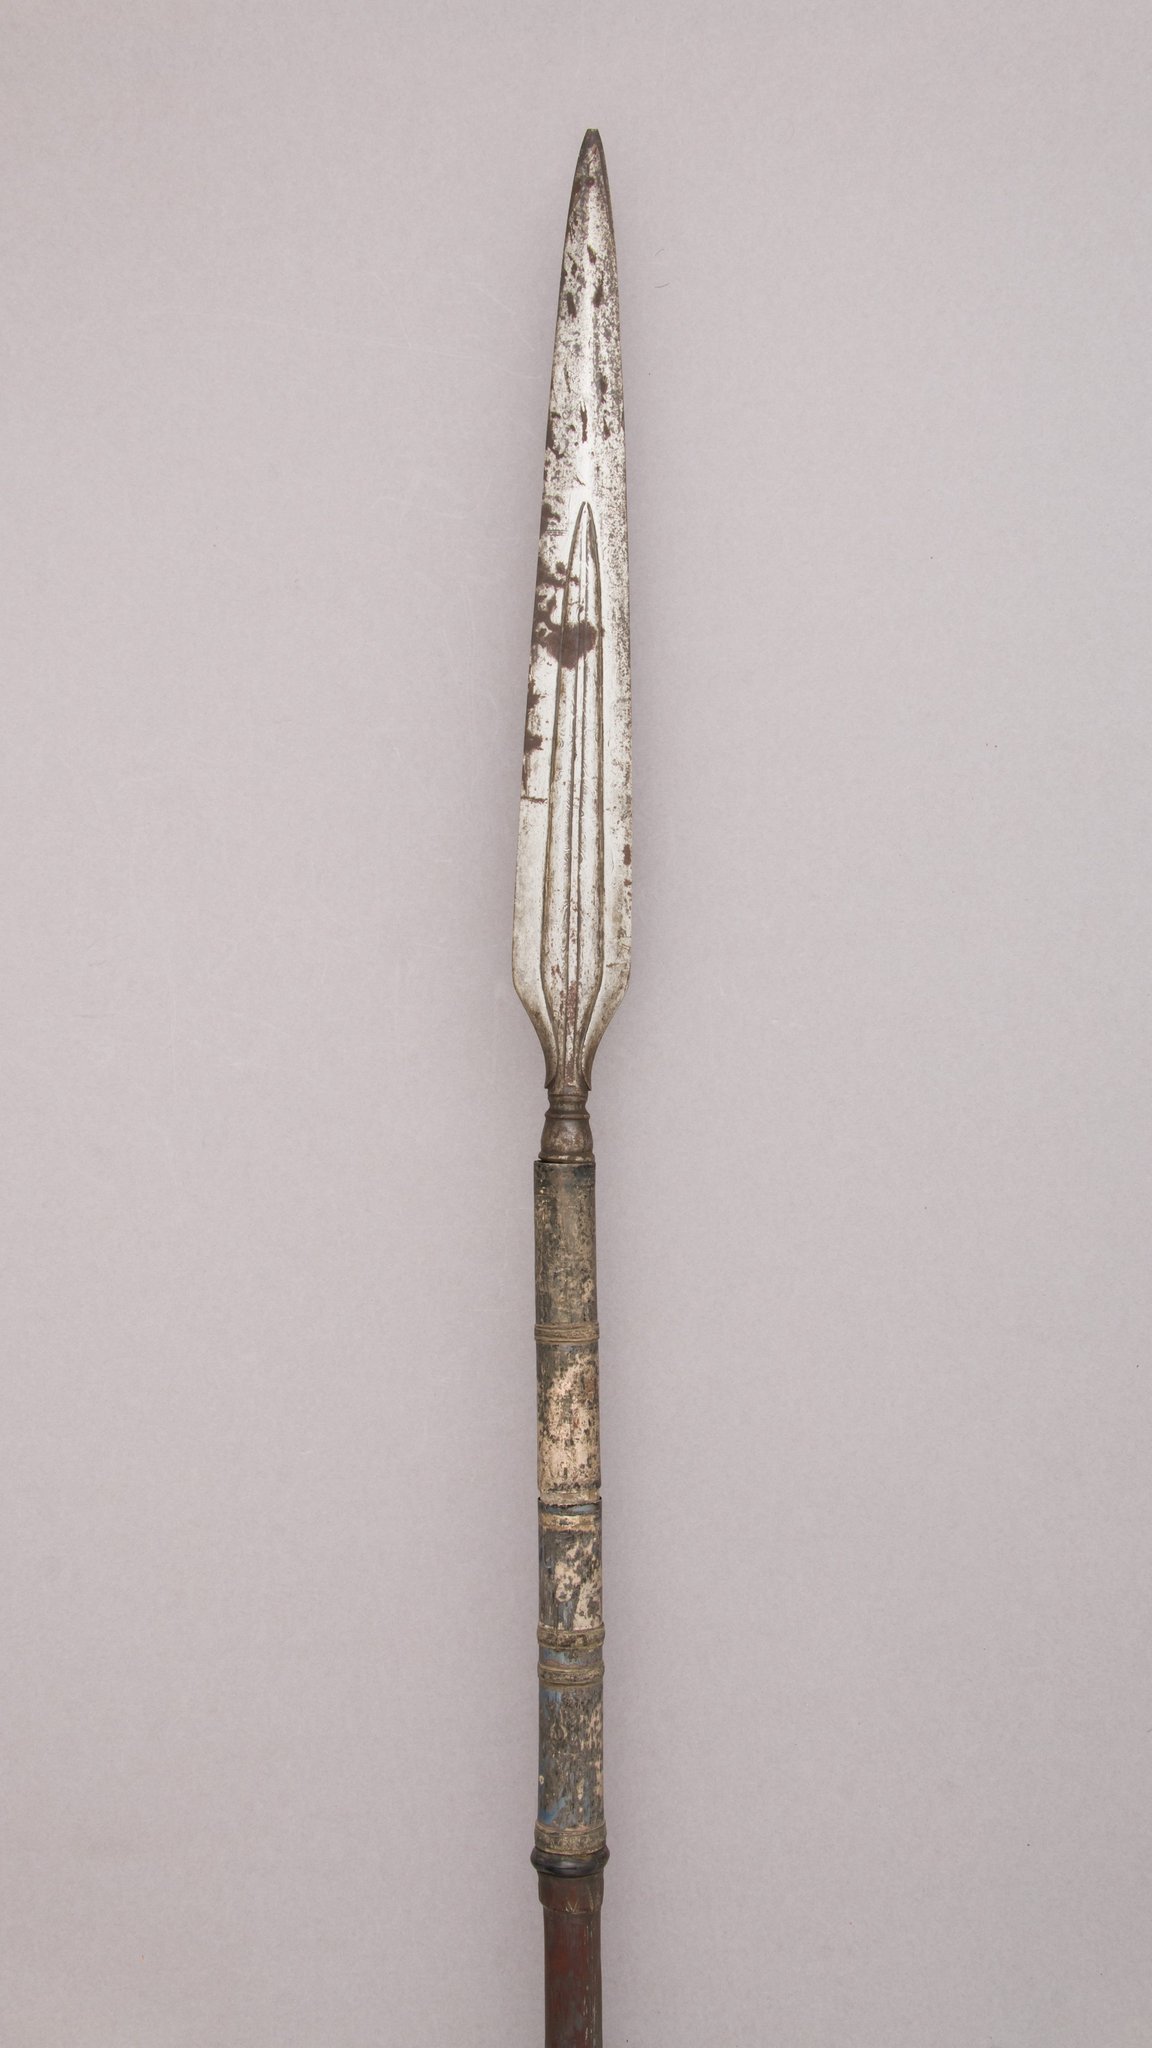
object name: spear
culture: philippine, jolo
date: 1701-1900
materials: horn, silver, steel, wood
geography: philippines